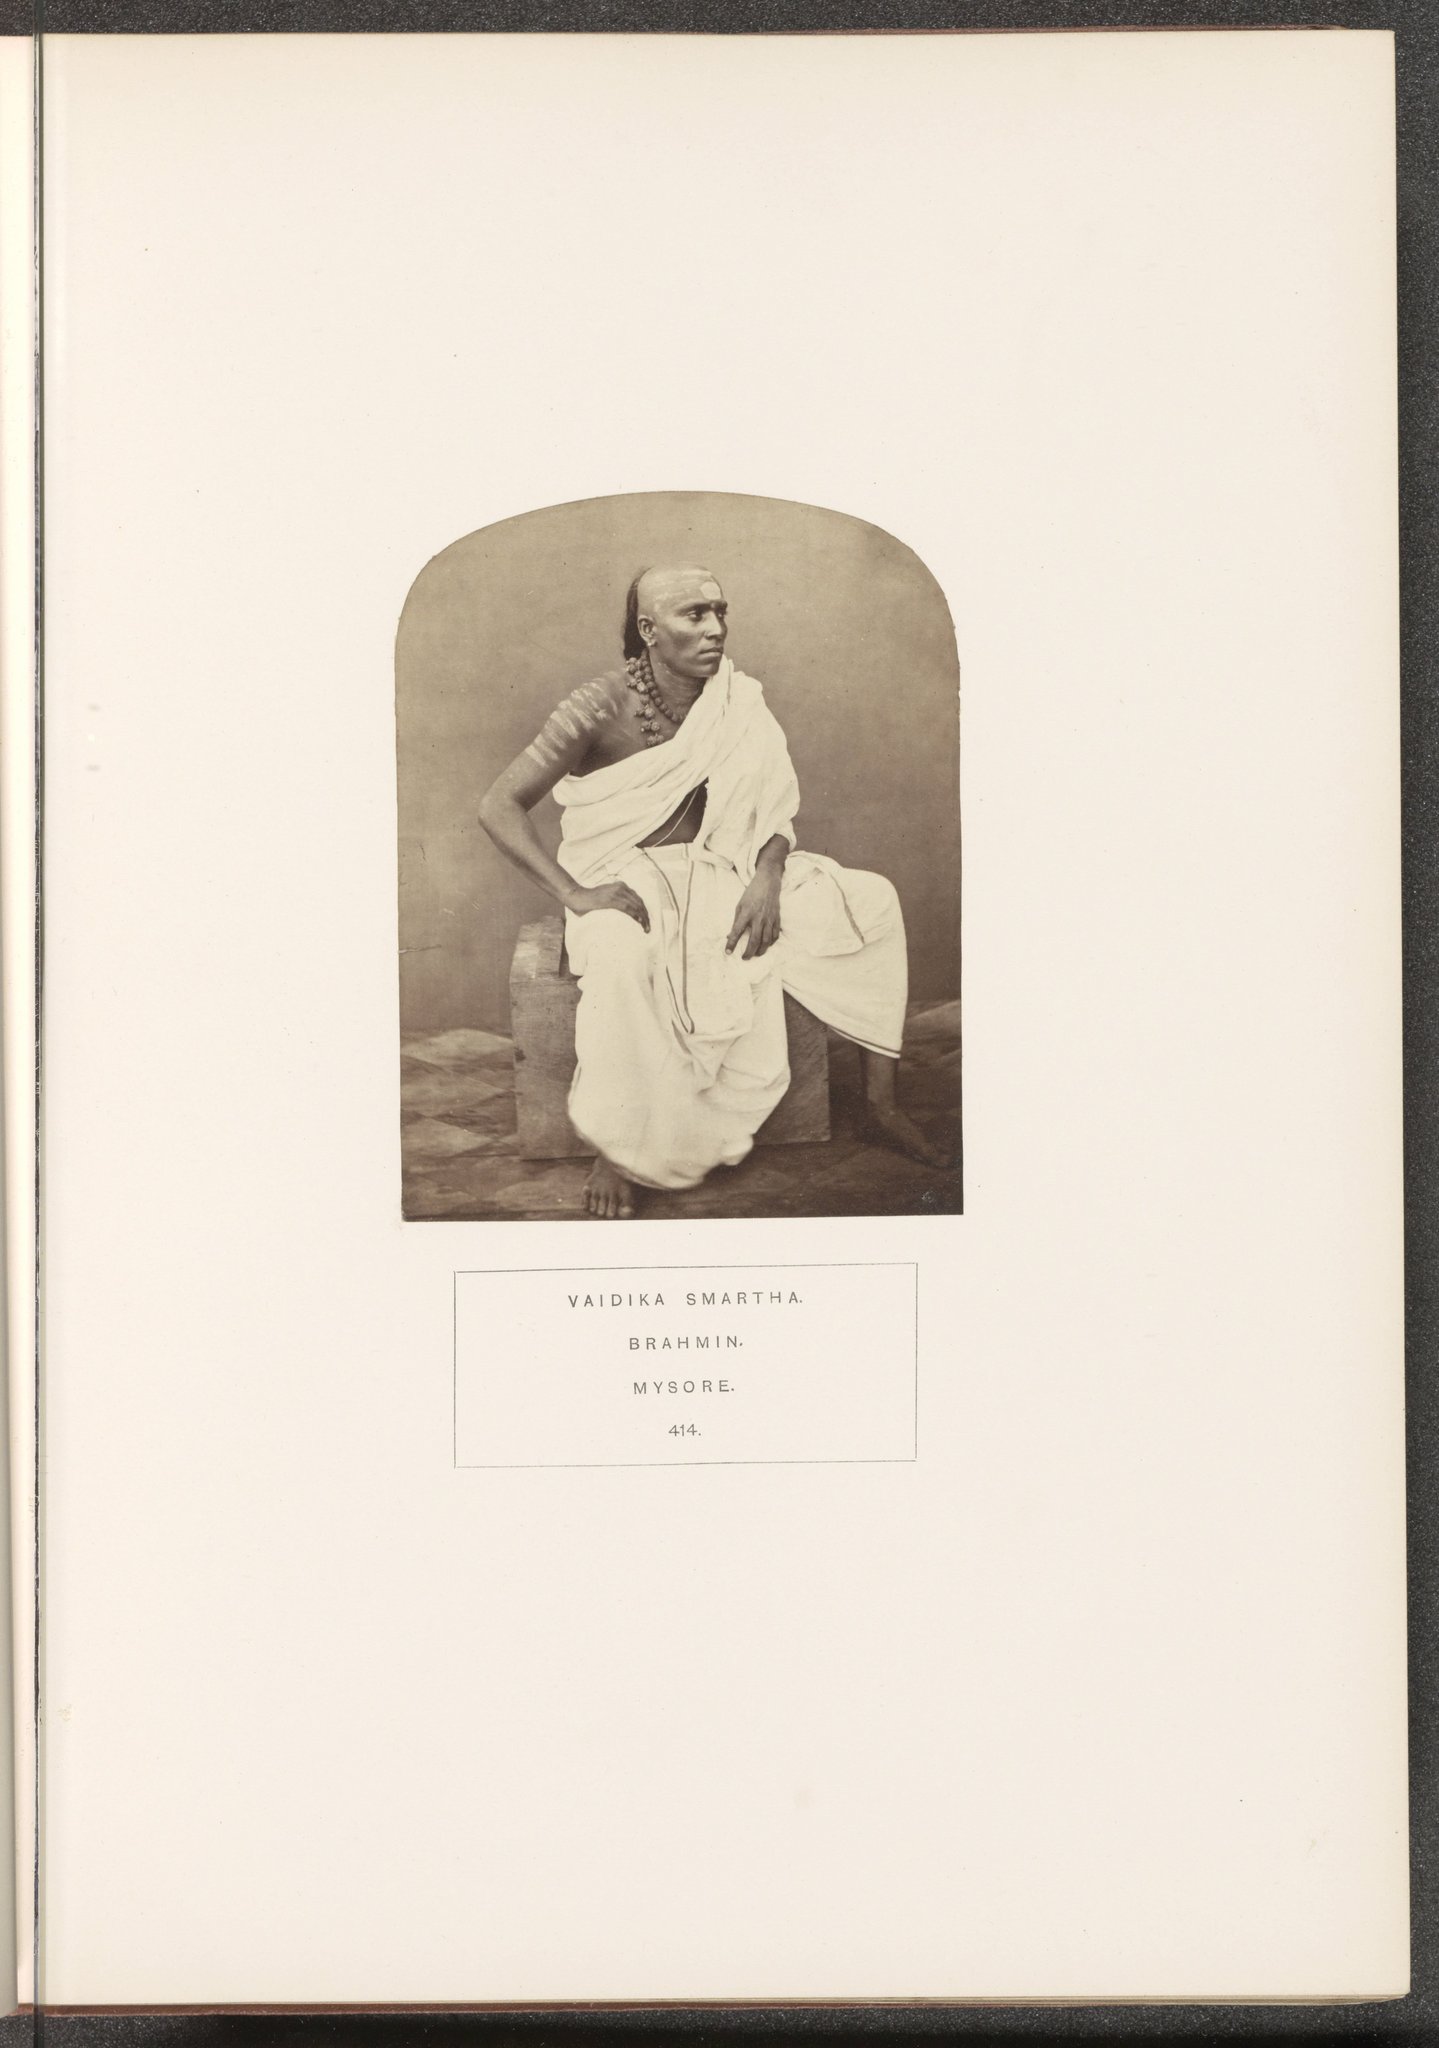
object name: page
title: Portrait of an unknown priest from the Smarta Brahmin community of Mysore, Karnataka, India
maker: Anonymous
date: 1865-1875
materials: photographic support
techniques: albumen print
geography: mysore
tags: brahma (supreme being, creator, etc. ~ hinduism, buddhism, jainism), human races; peoples; nationalities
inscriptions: inscription: ‘VAIDIKA SMARTHA./ BRAHMIN./ MYSORE.’, number: ‘414.’